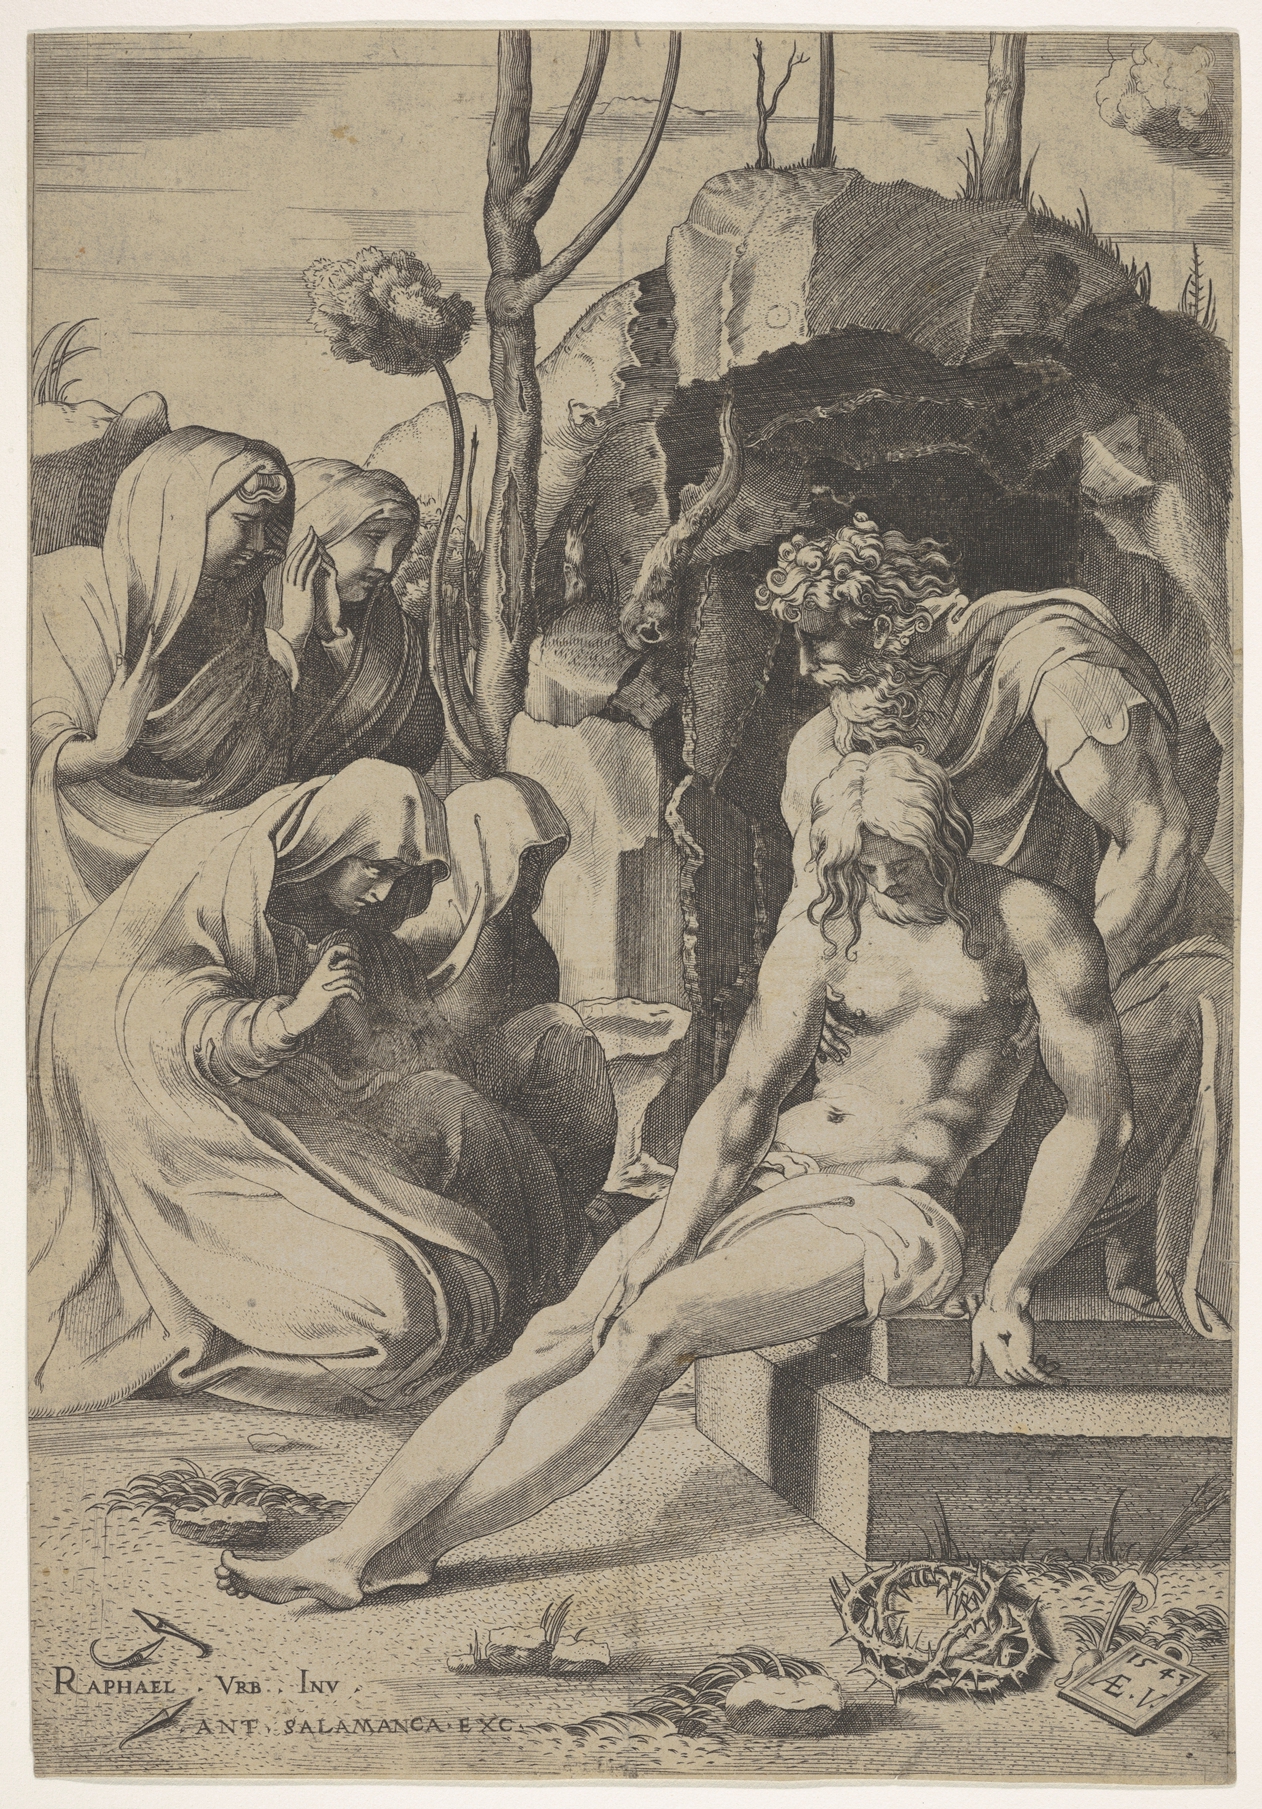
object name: print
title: Entombment of Christ, whose chest is grasped by Joseph of Arimathea, with two kneeling and two standing female mourners at left and crown of thorns at bottom right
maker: enea vico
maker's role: artist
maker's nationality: italian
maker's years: 1523-1567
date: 1543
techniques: engraving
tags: women,christ,entombment